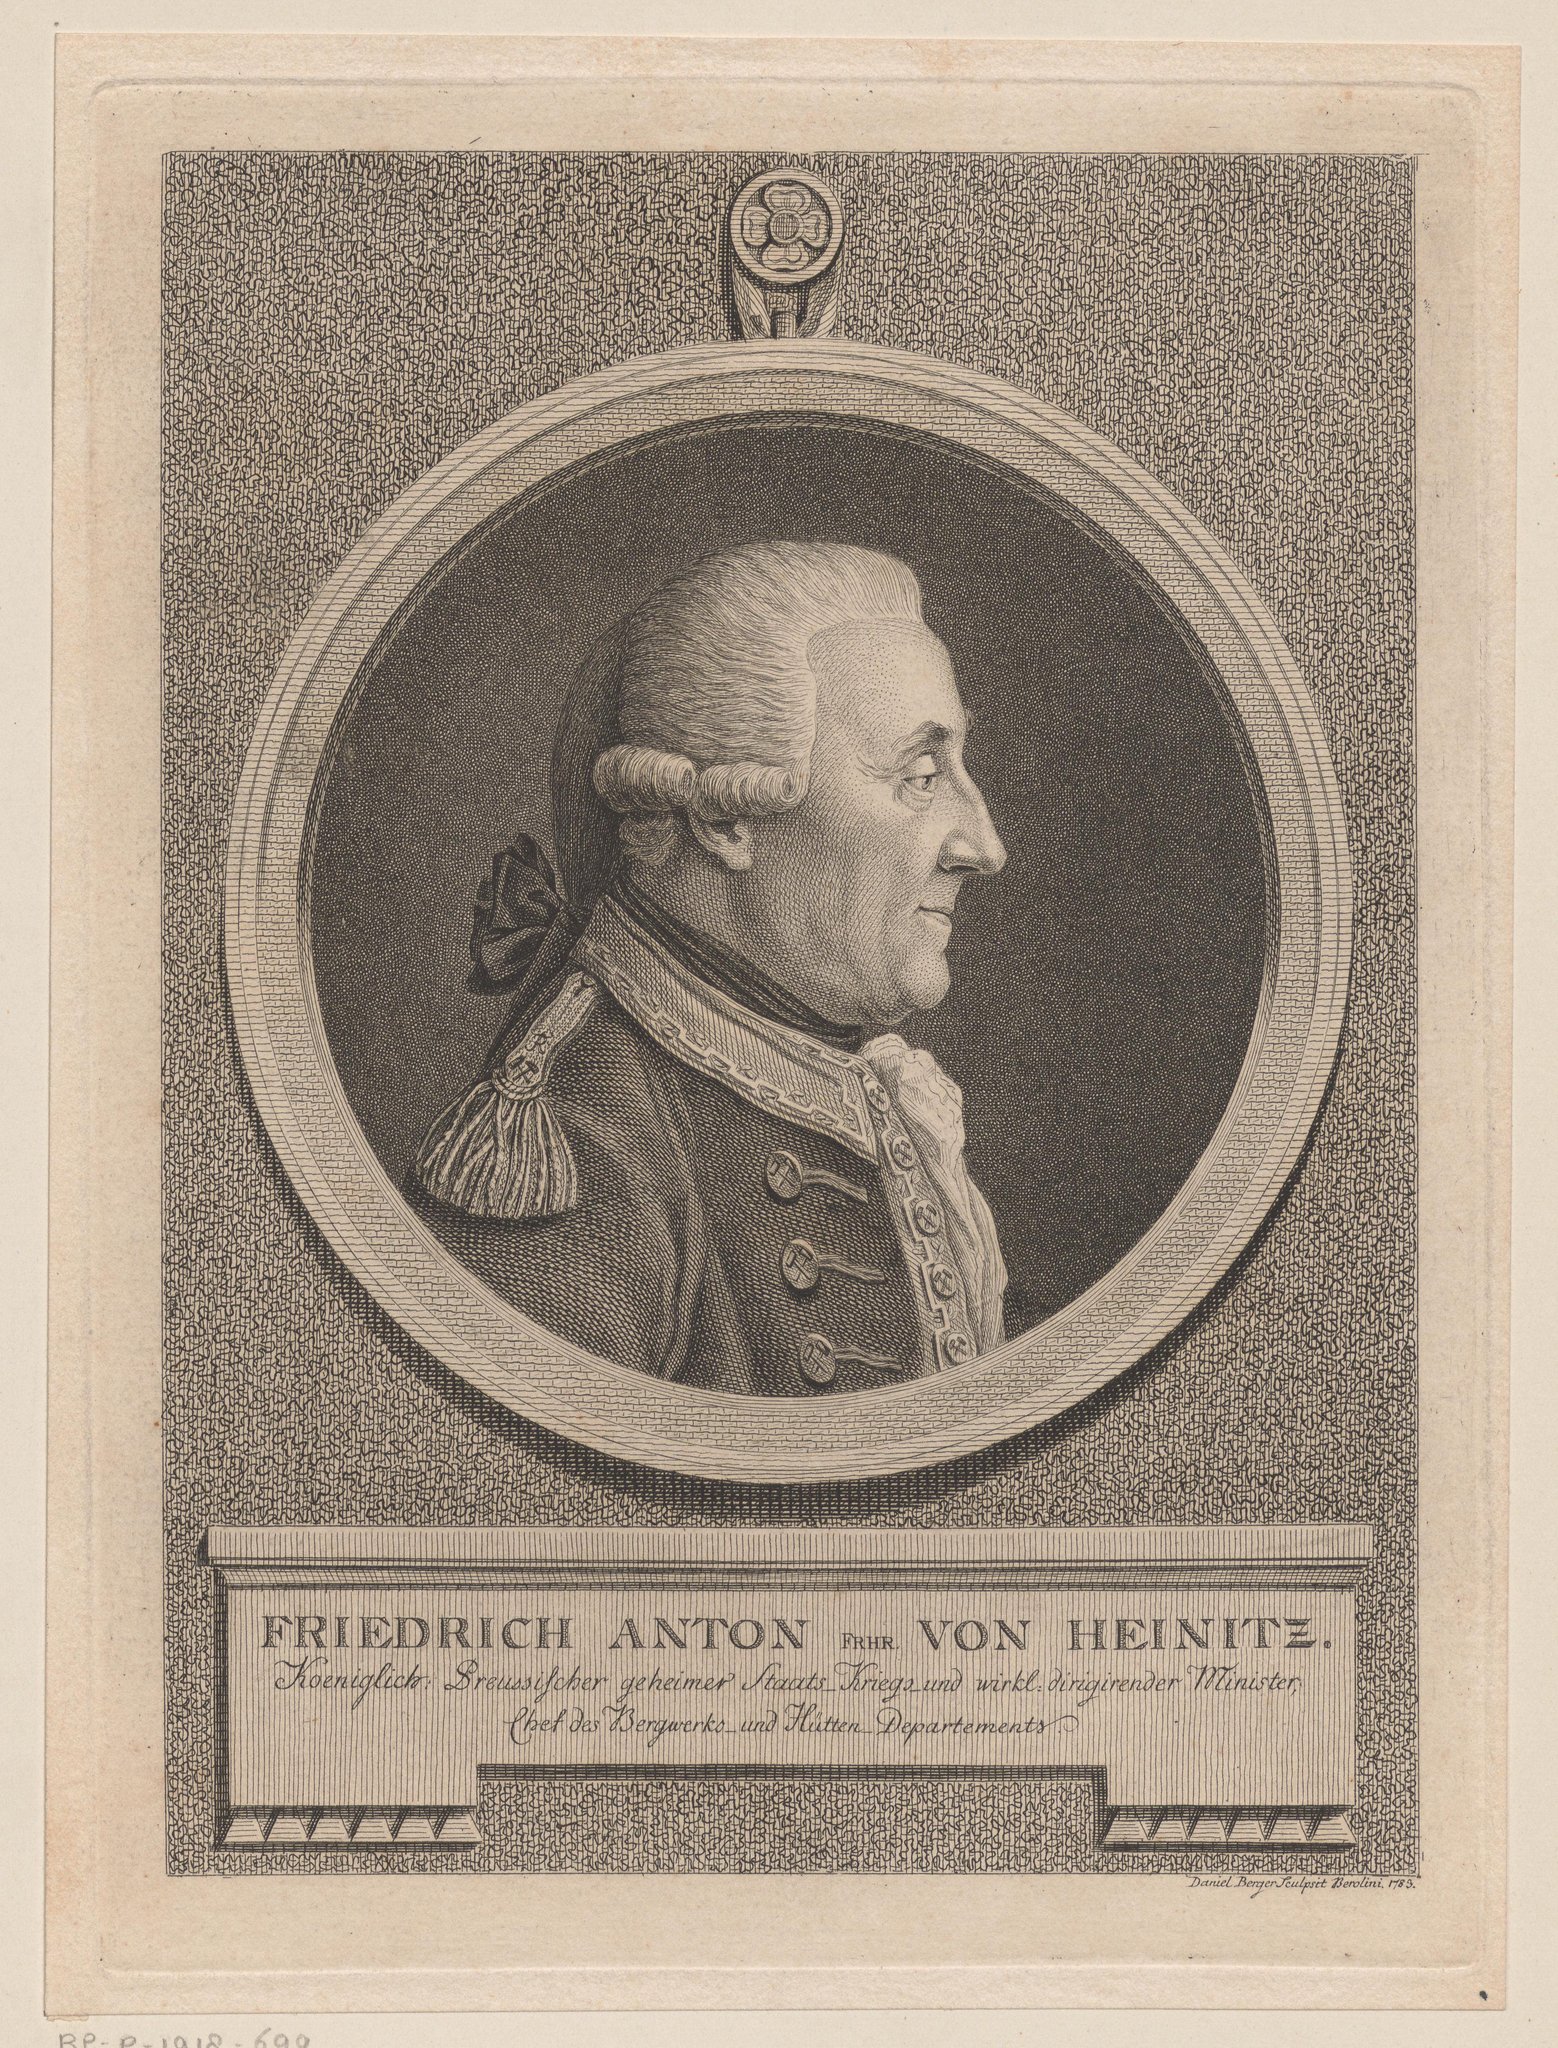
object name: print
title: Portret van Friedrich Anton von Heynitz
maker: daniel berger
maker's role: print maker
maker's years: 1744-1824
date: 1783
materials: paper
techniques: engraving, etching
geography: berlin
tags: historical persons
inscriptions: collector's mark: Lugt 2233